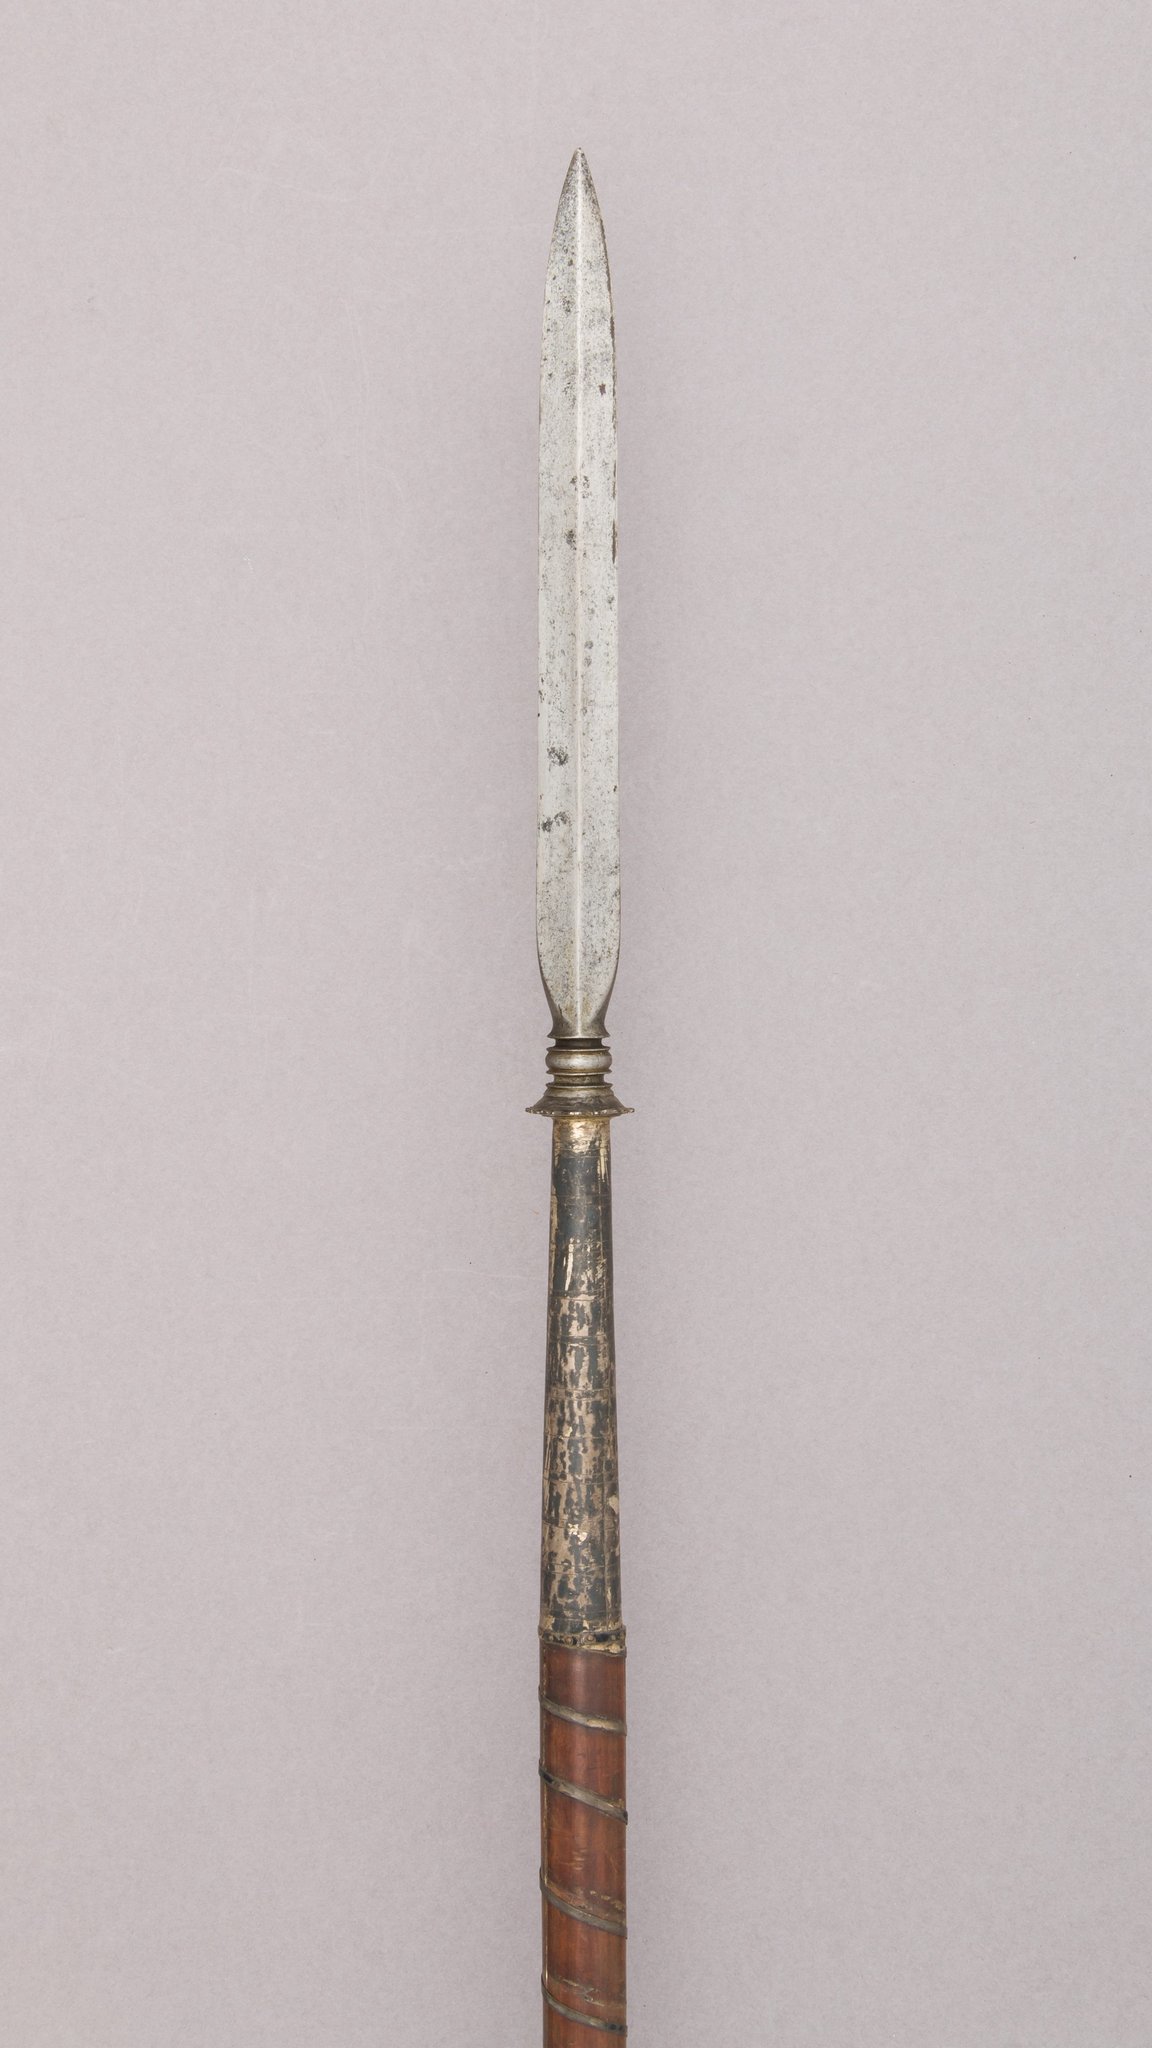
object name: spear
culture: javanese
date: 1501-1900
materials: diamond, silver, steel, wood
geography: indonesia